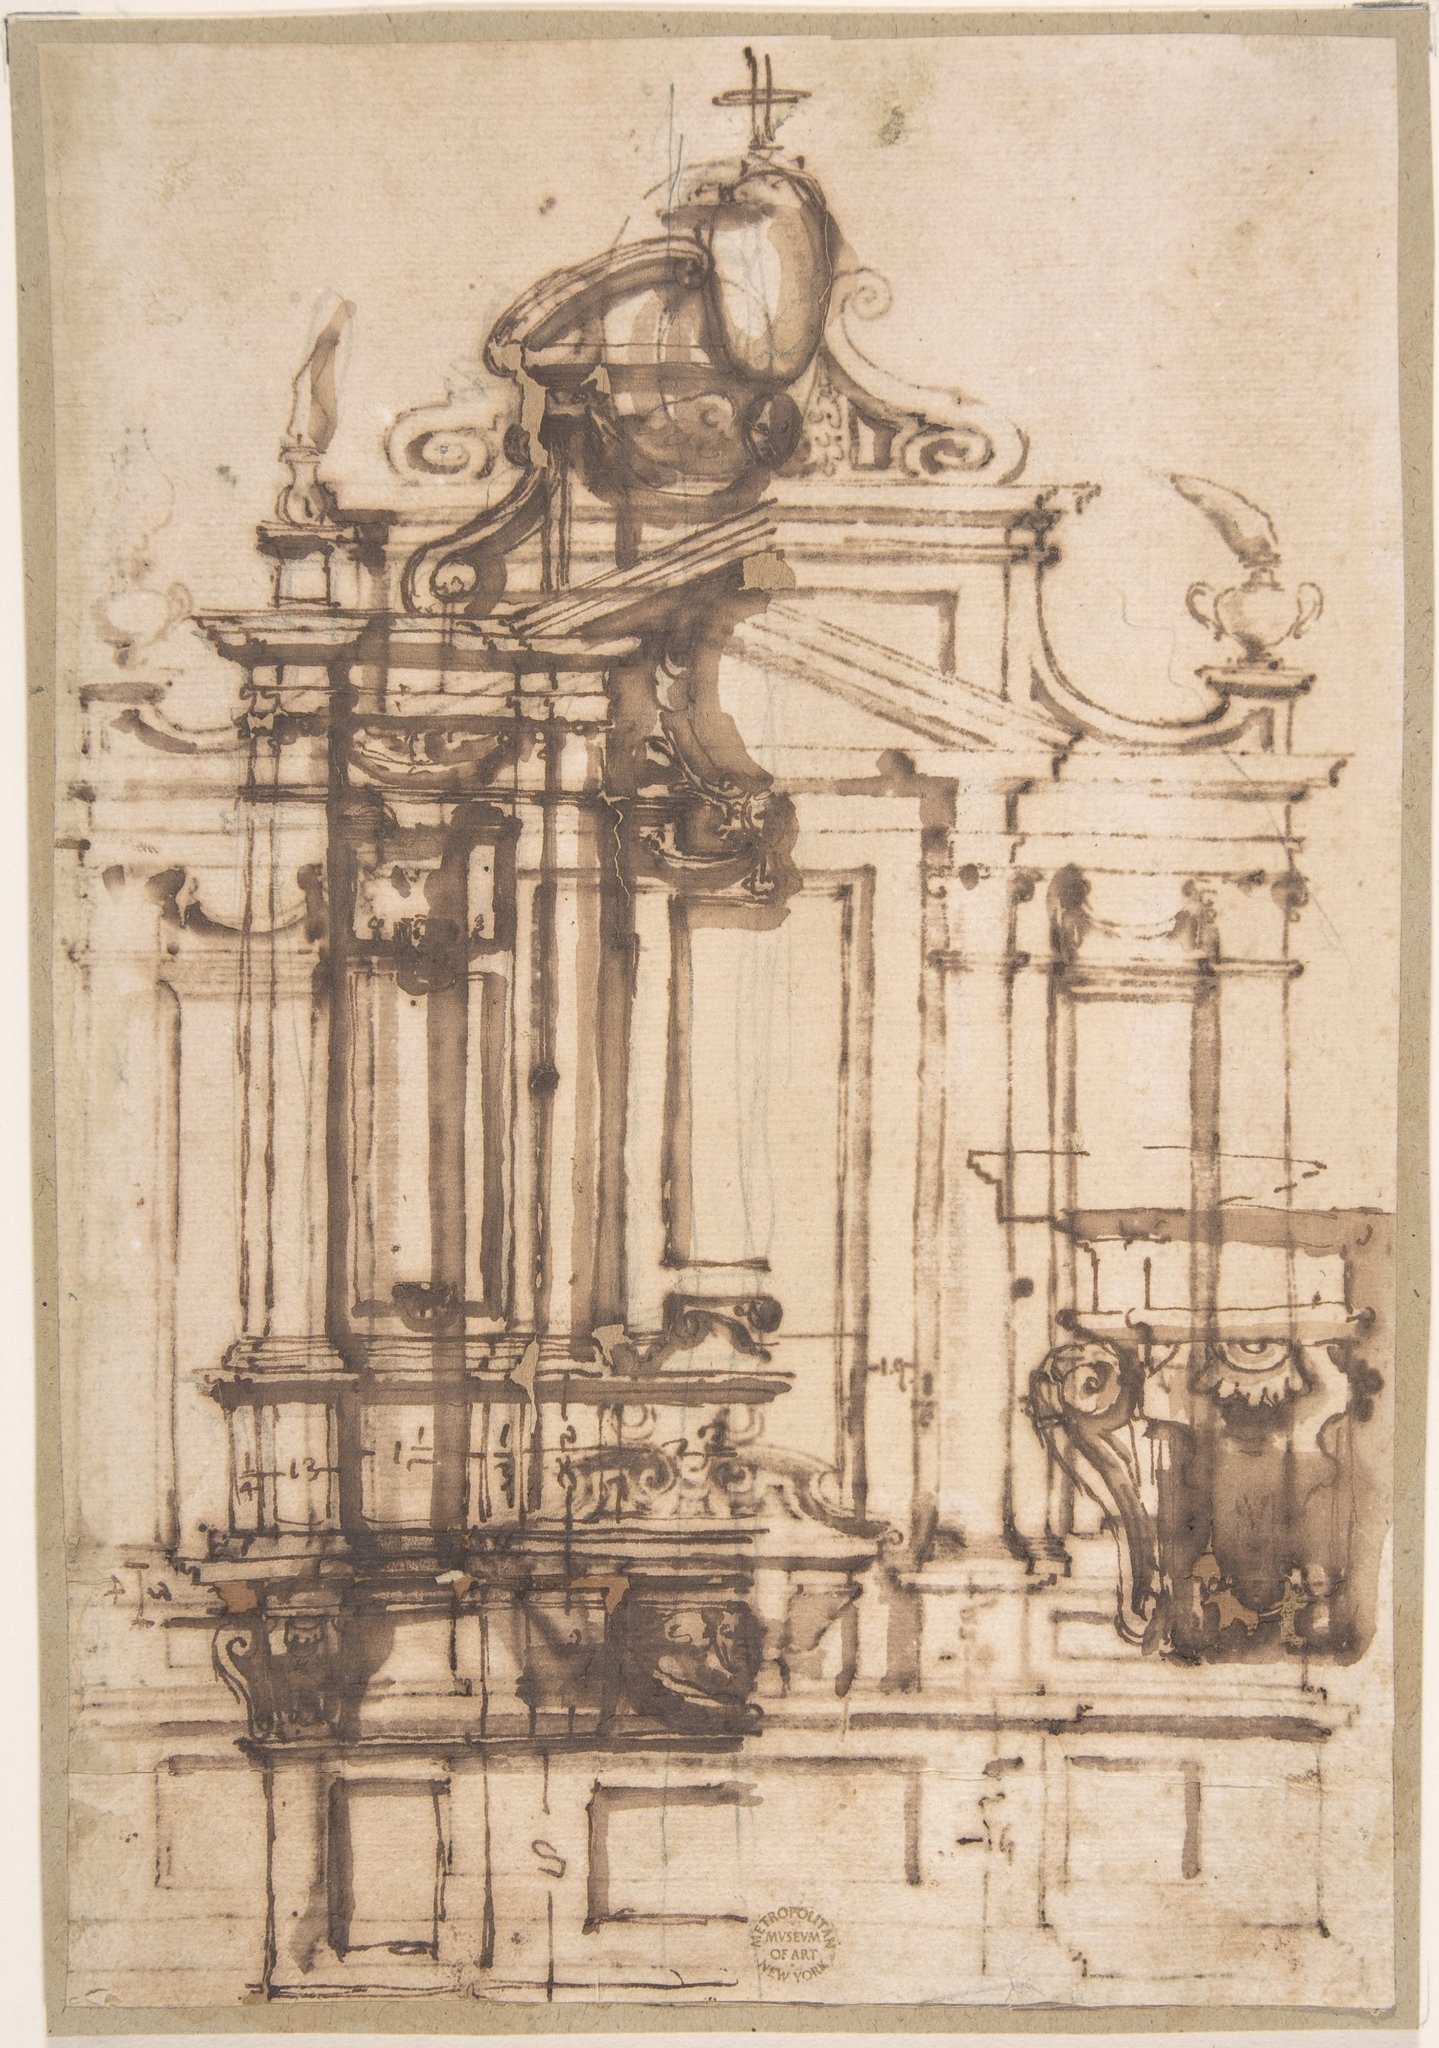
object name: drawing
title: Architectural Drawing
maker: anonymous, italian, 16th century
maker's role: artist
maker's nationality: italian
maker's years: 1550-1600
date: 1501-1600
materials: ink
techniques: pen, wash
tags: architecture